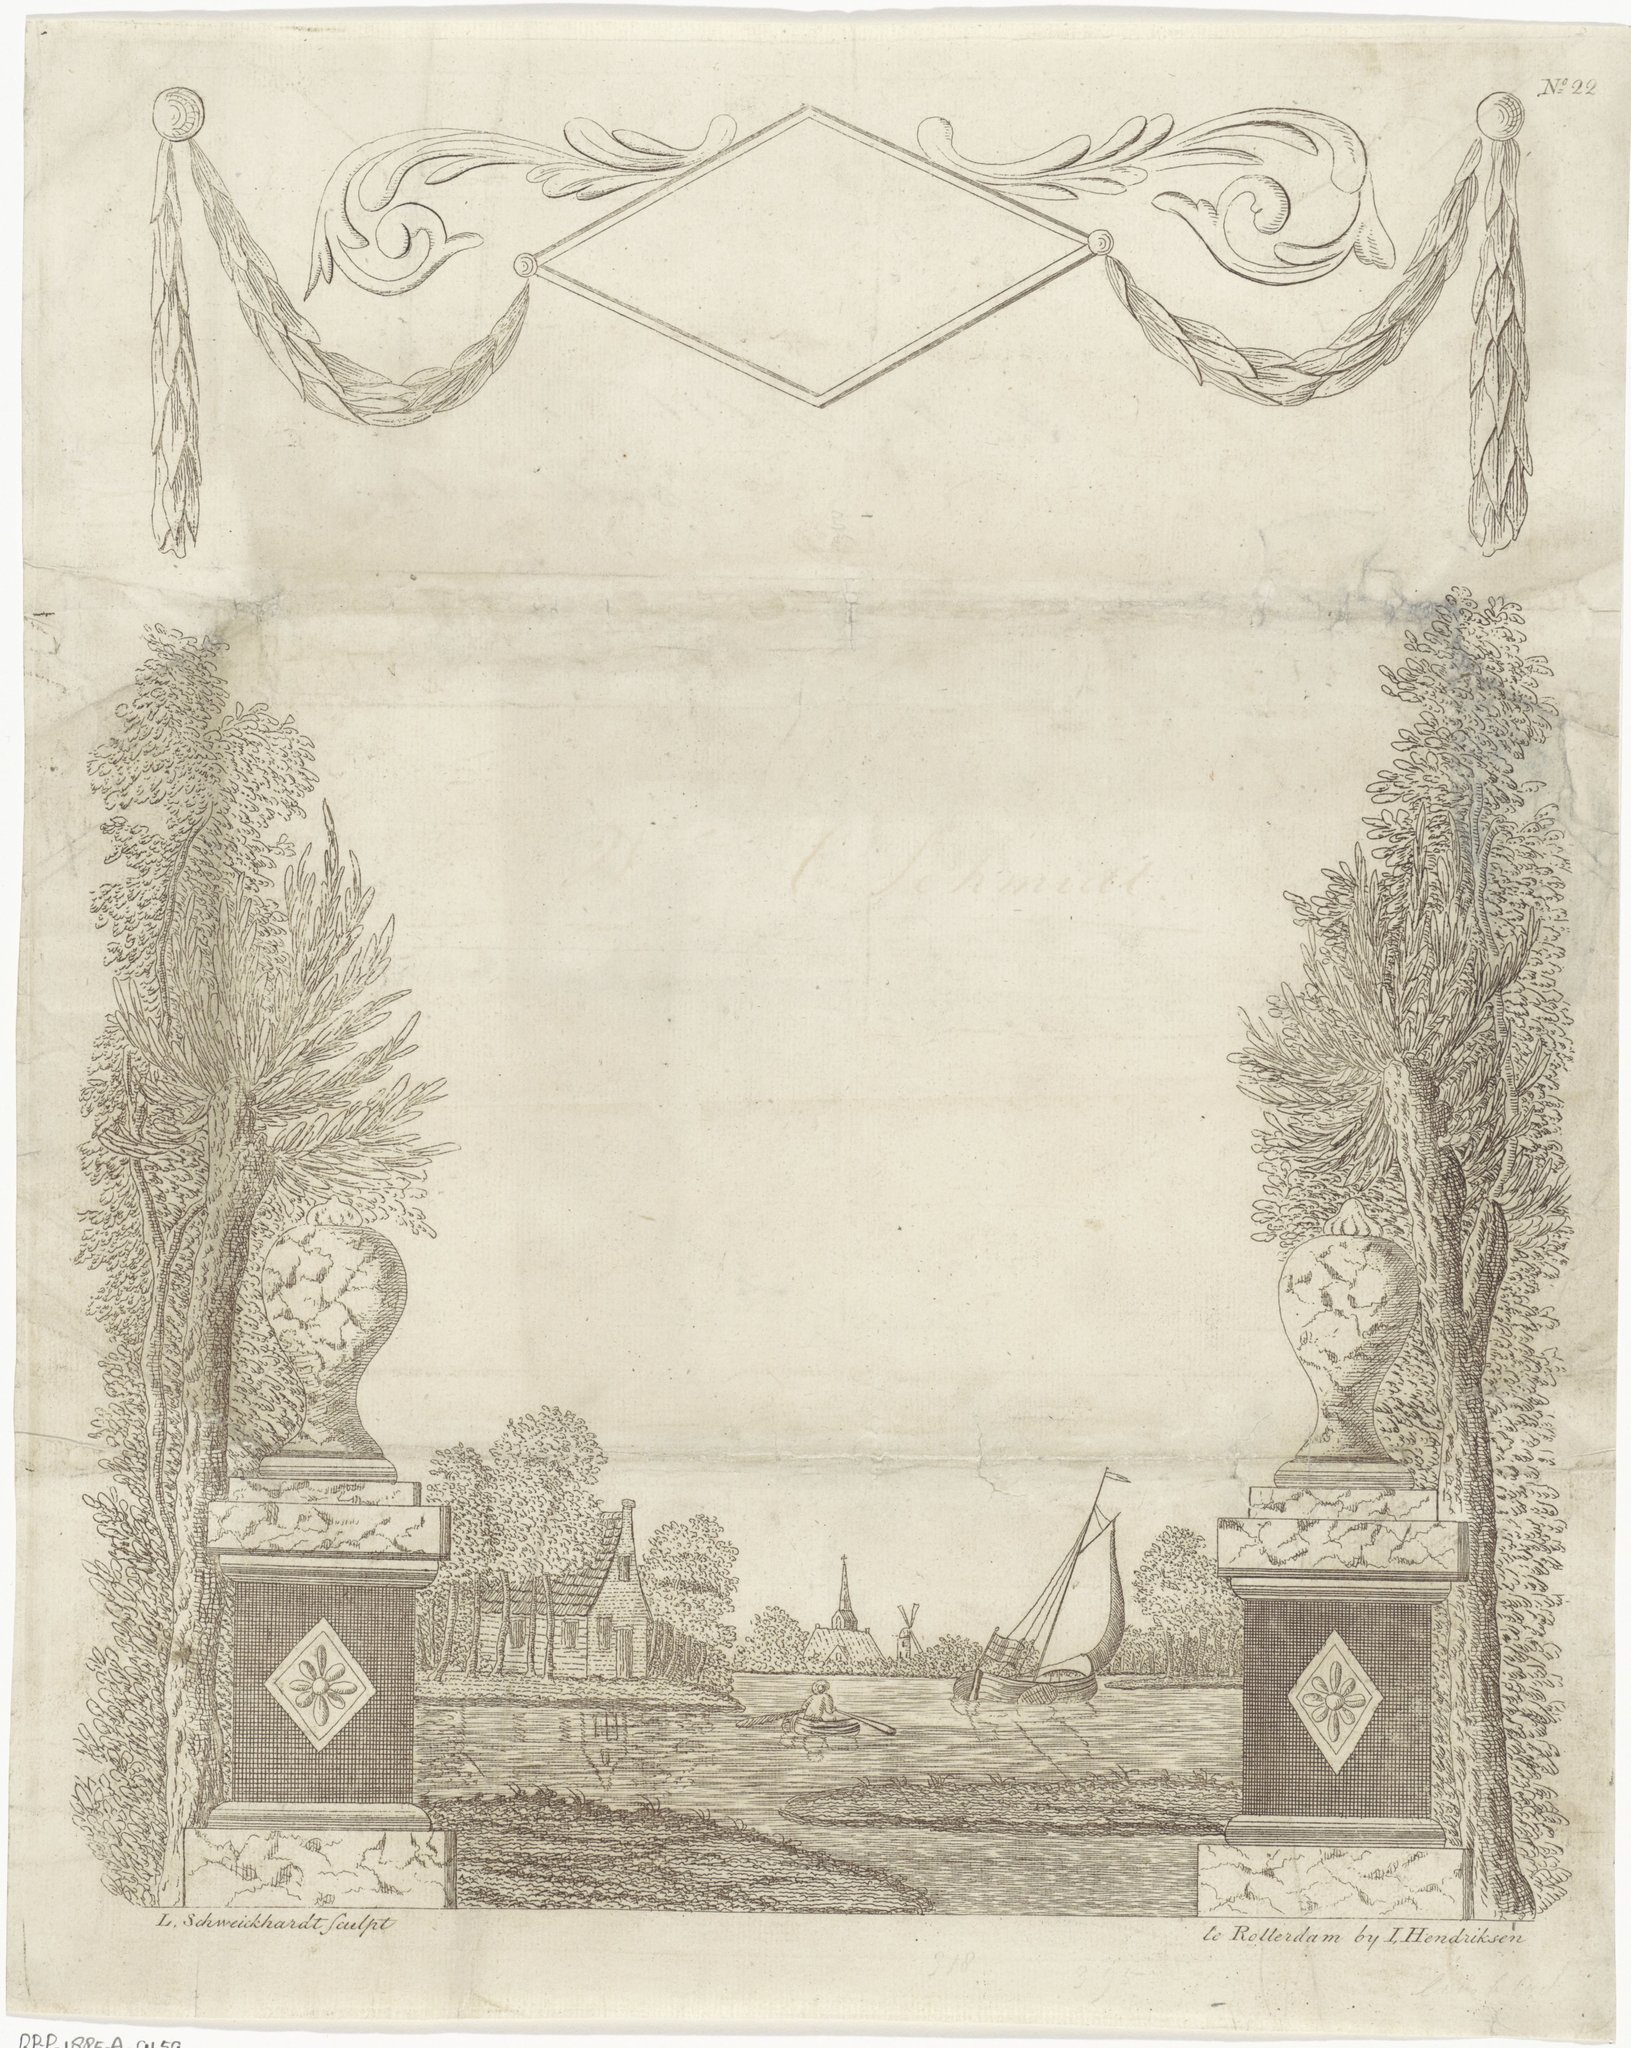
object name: wensbrief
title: Wensbrief met decoratief kader met een dorpsgezicht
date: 1793-1862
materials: paper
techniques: etching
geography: northern netherlands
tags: prospect of village, silhouette of village, rowing-boat, canoe, etc., garden vase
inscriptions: collector's mark: Lugt 2228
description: Decoratieve prent voor een geschreven wens. Aan weerszijden bomen naast een vaas op een piëdestal. In het midden een gezicht op een dorp langs een rivier. Op de rivier een roeiboot en een zeilschip. Bovenaan tussen guirlandes een leeg ruitvormig kader. Rechtsboven genummerd: N. 22.